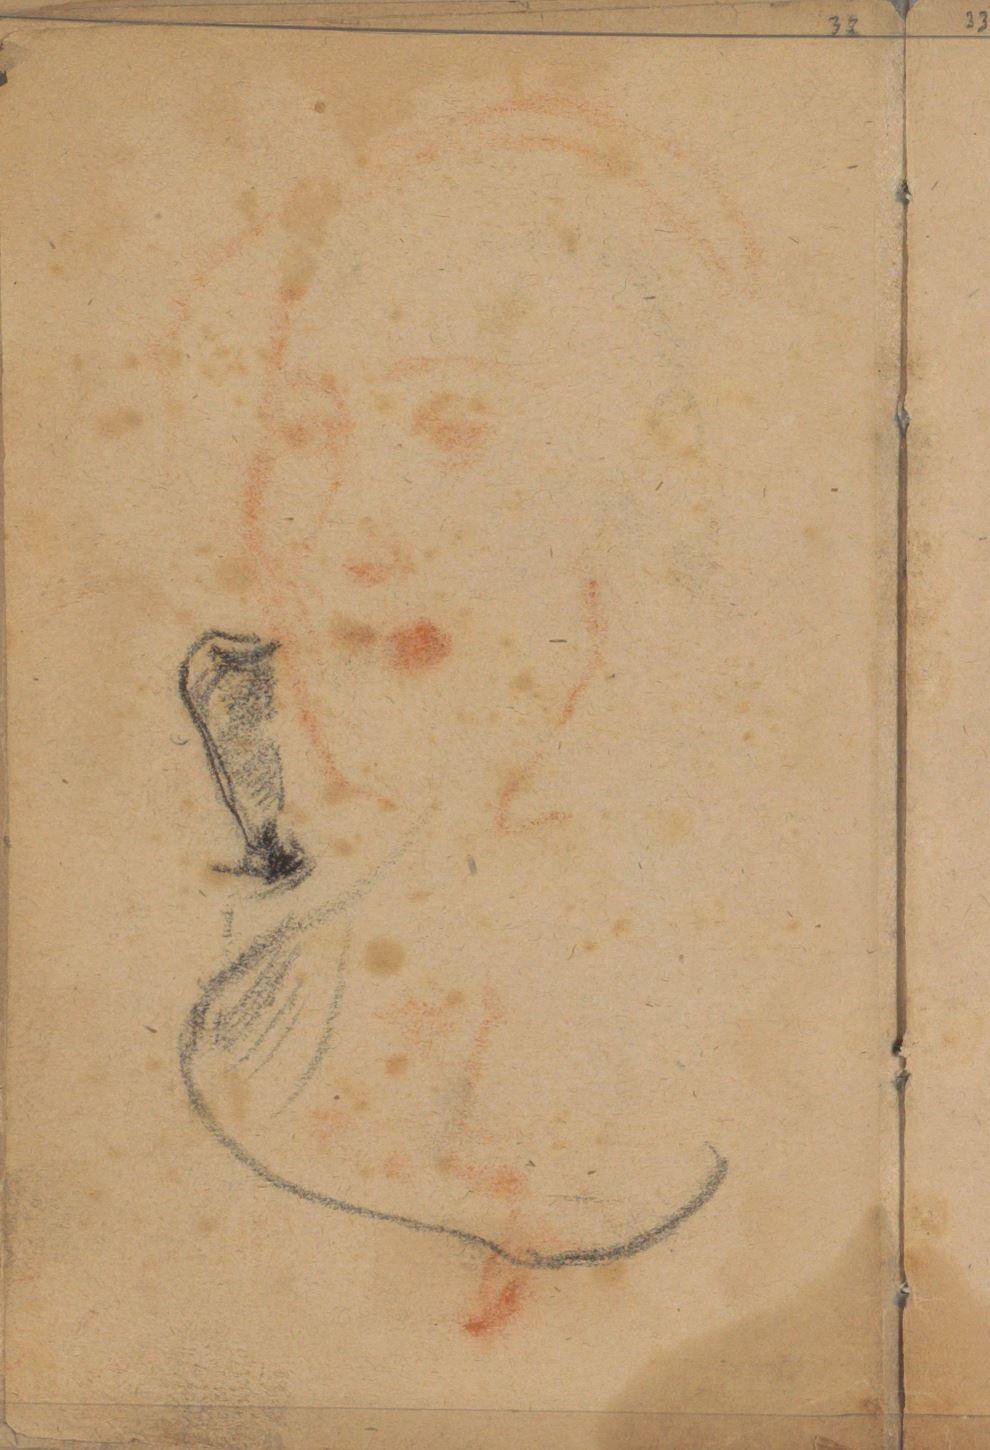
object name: sketchbook leaf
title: Studie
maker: george hendrik breitner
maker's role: draughtsman, painter, print maker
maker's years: 1857-1923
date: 1881-1883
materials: chalk, paper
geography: south holland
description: Studie. Pagina 32 uit een schetsboek met 70 bladen.